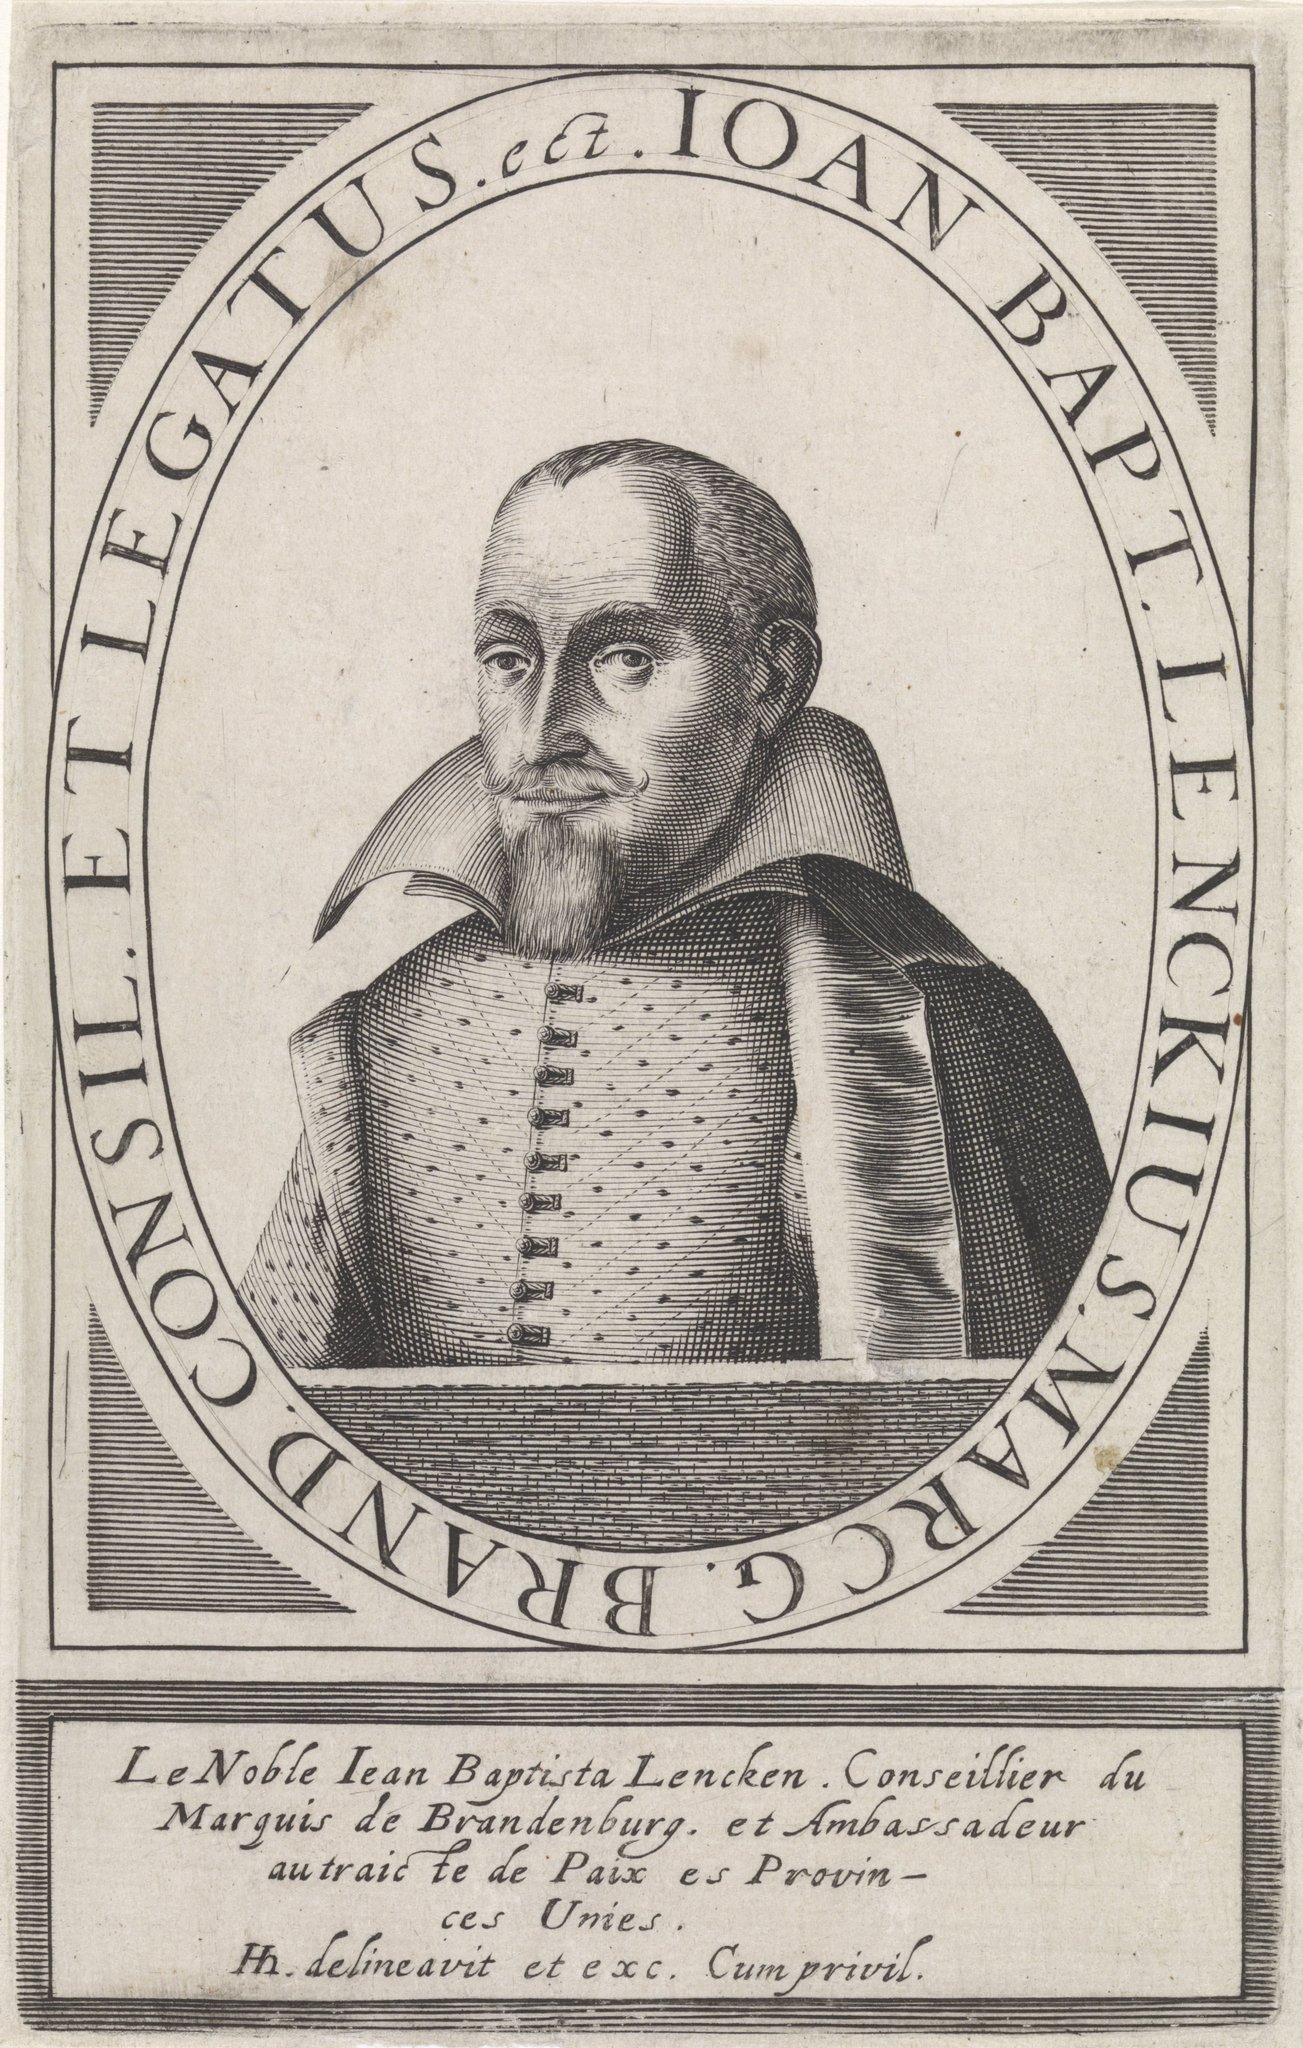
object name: print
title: Belgiae Pacificatorum Vera Delineatio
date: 1608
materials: paper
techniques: engraving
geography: the hague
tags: politician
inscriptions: collector's mark: Lugt 2228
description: Buste naar links van Jan Baptist Lencken, in een ovale omlijsting, waarop een randschrift met zijn naam en titel in het Latijn. Onder het portret vier regels in het Frans. Prent uit een serie van veertig portretten van vredestichters in de Nederlanden.